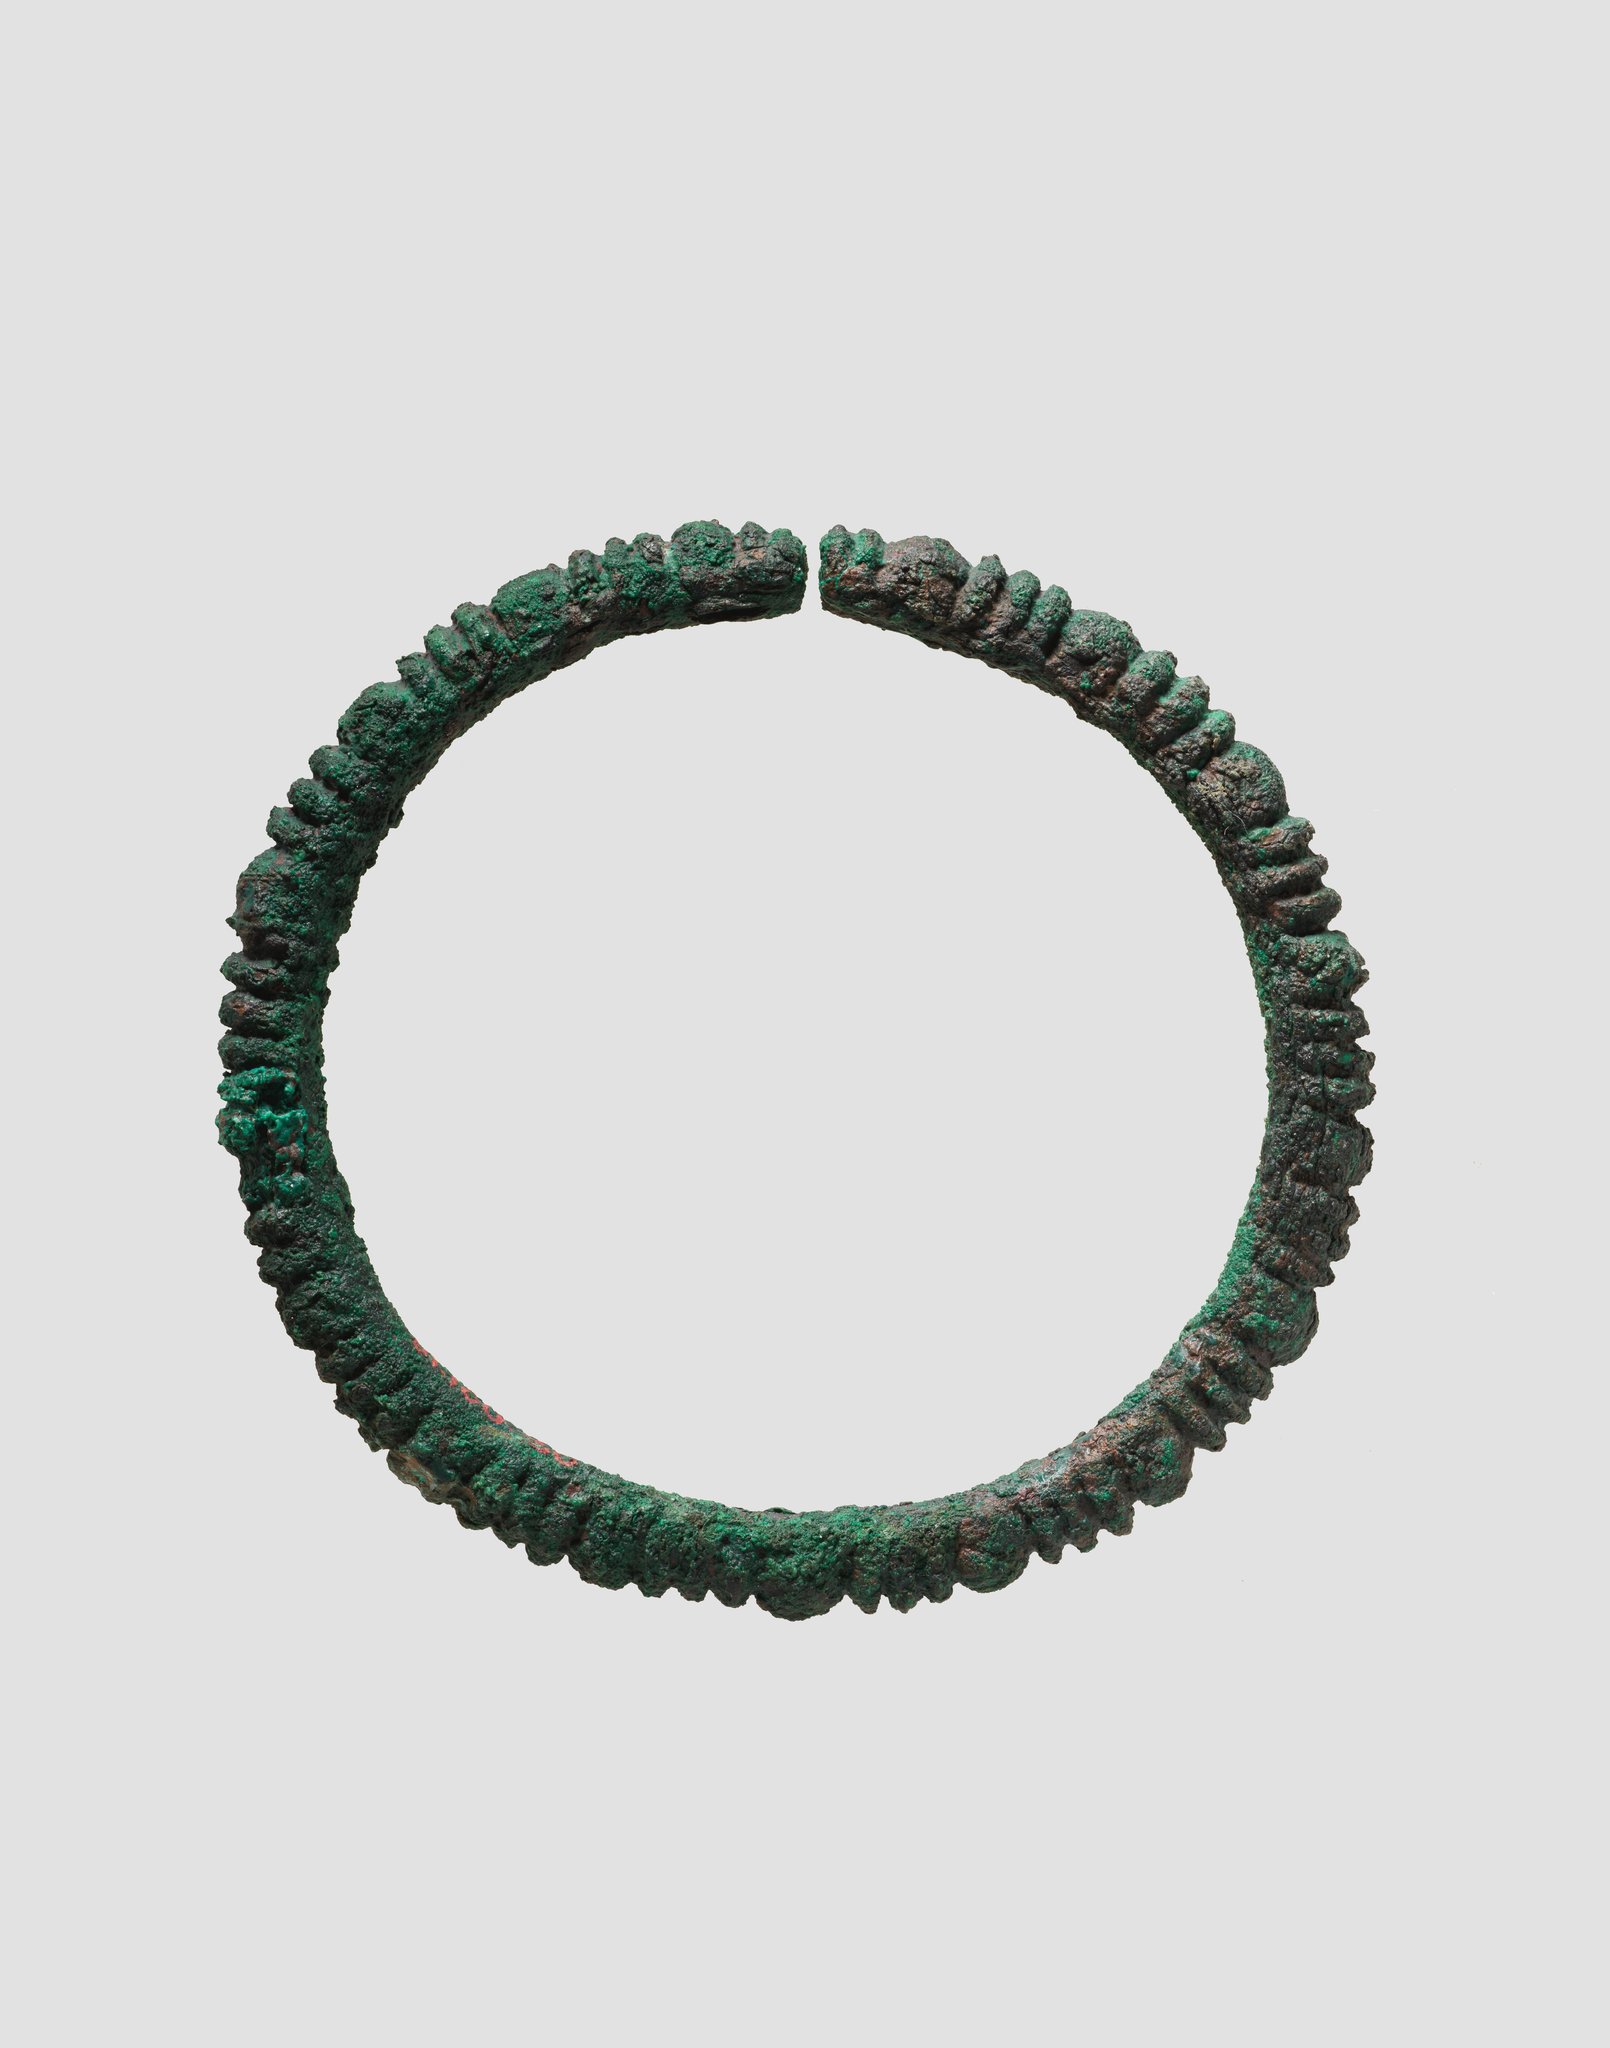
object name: bracelet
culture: iranian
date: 900-801 BCE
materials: bronze, copper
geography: iran